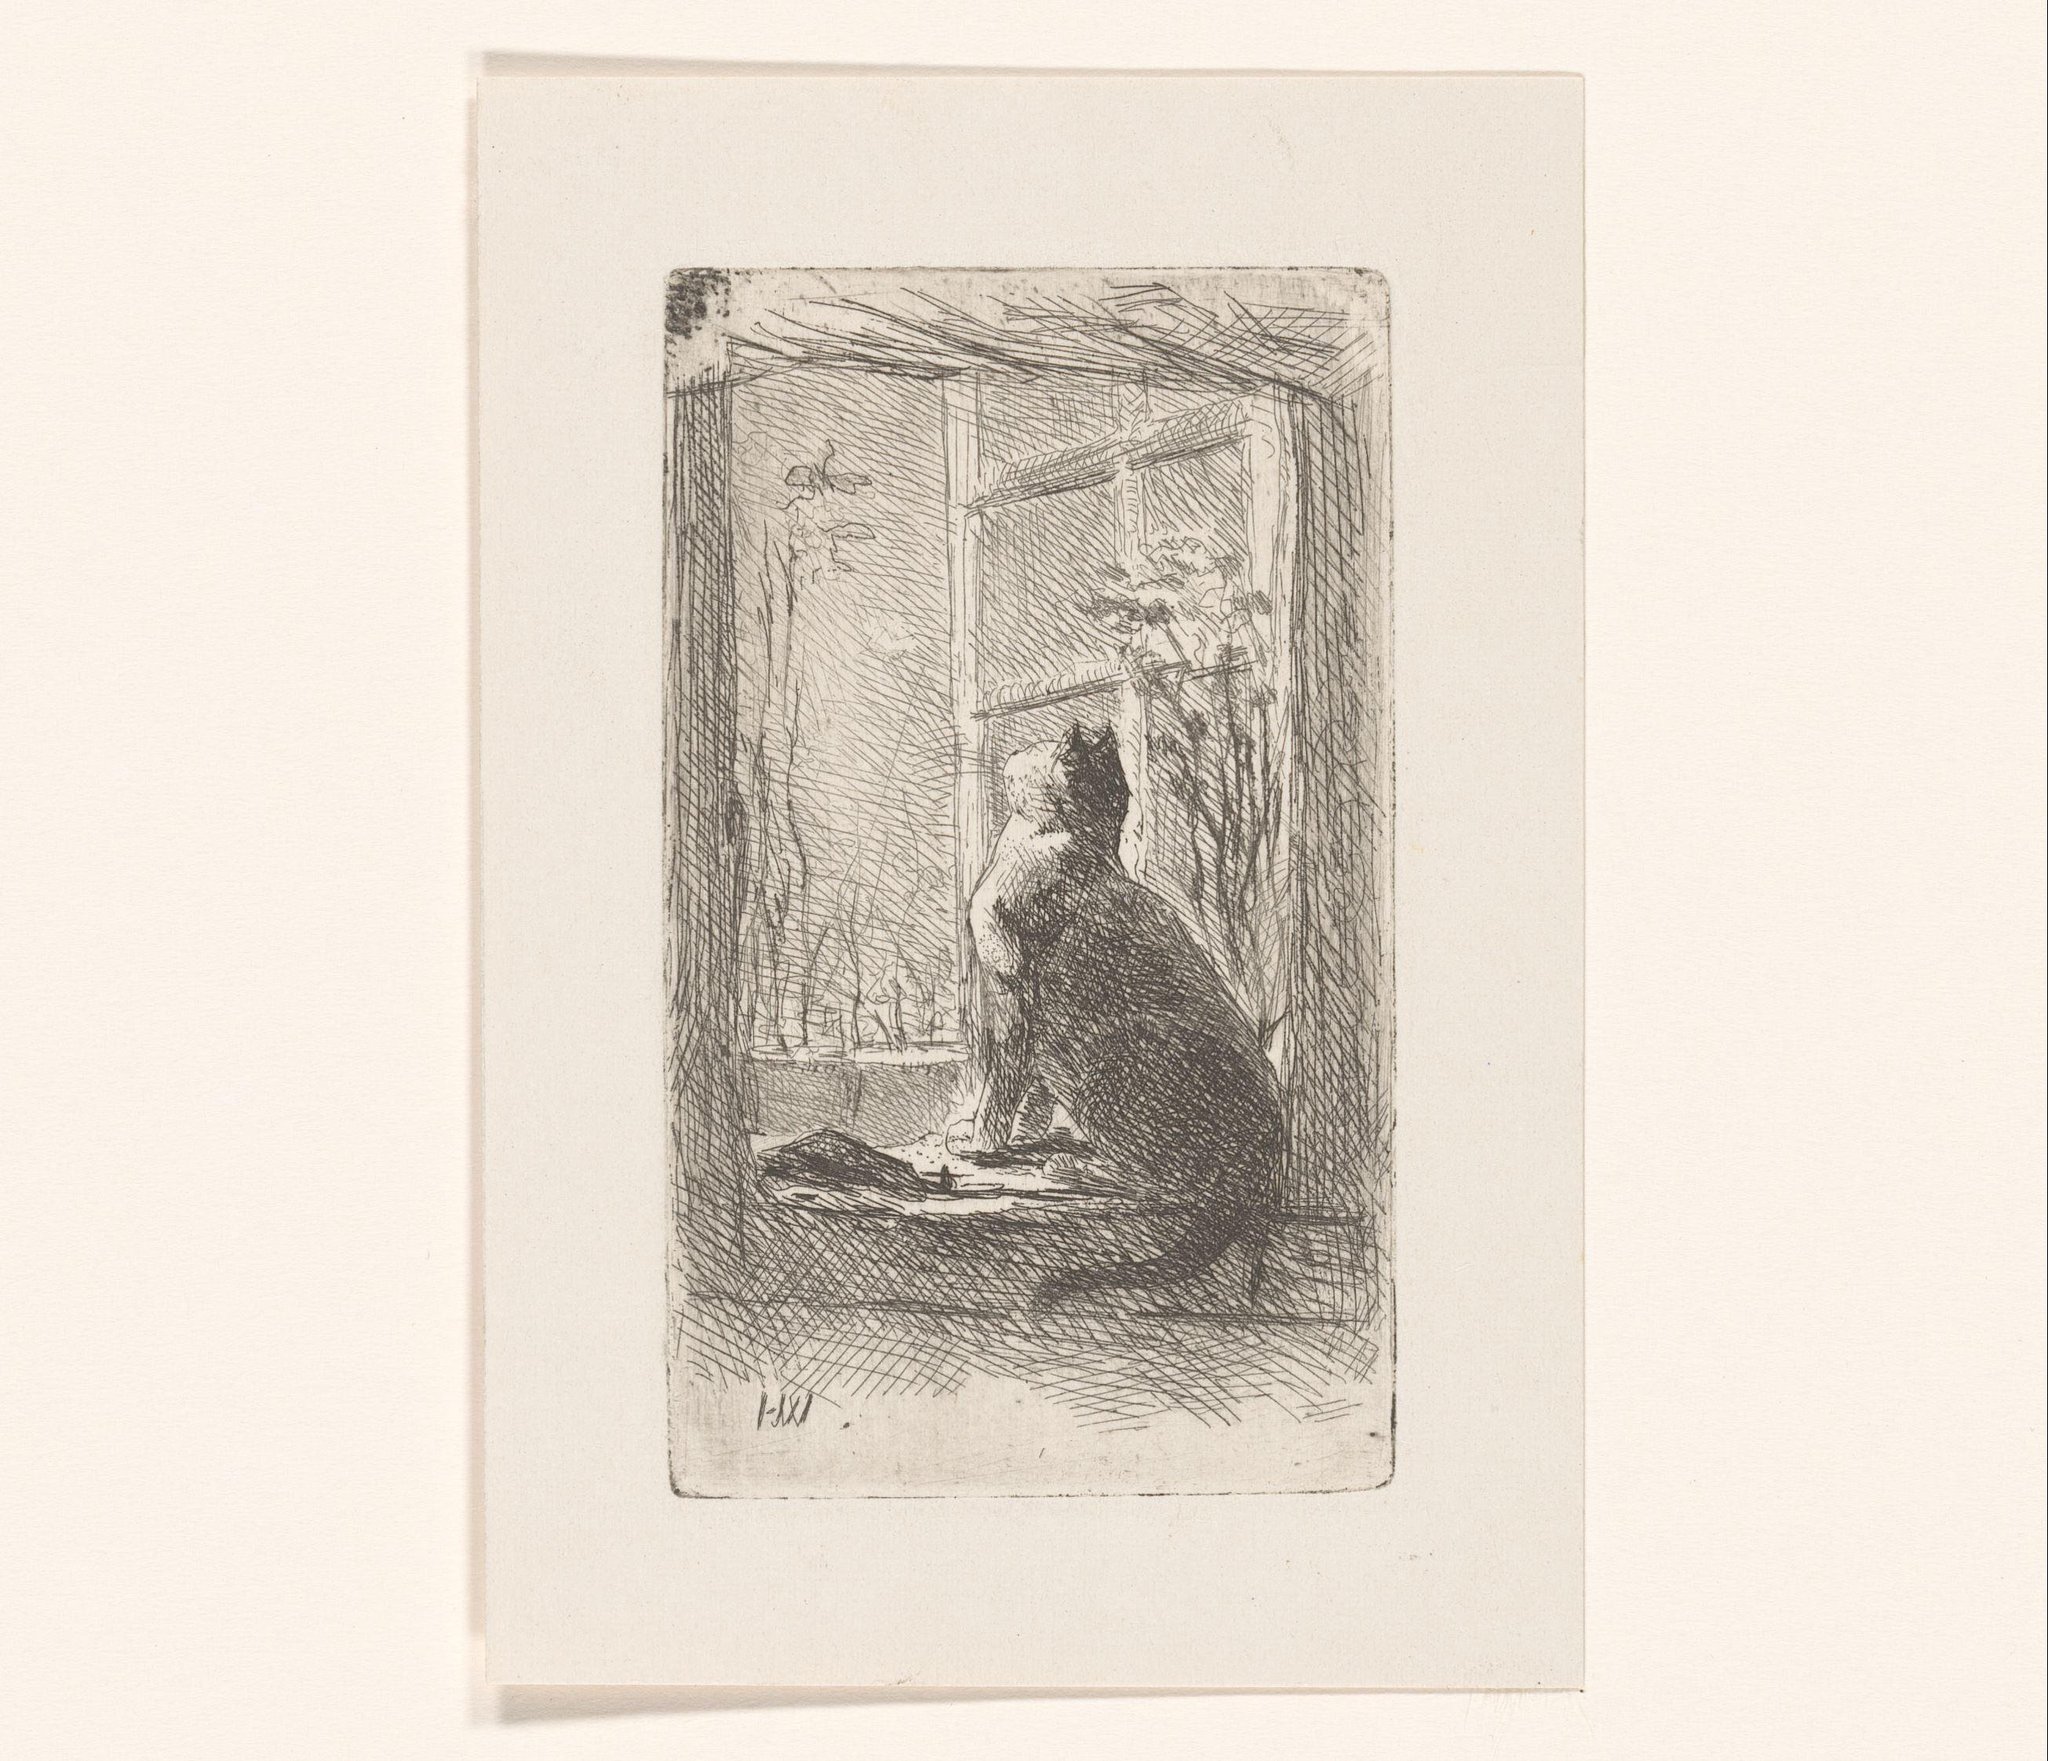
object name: print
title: Kat in een venster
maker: herman johannes van der weele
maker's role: print maker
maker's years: 1852-1930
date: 1862-1930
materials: paper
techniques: etching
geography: netherlands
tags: cat, open window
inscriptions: collector's mark: Lugt 2228